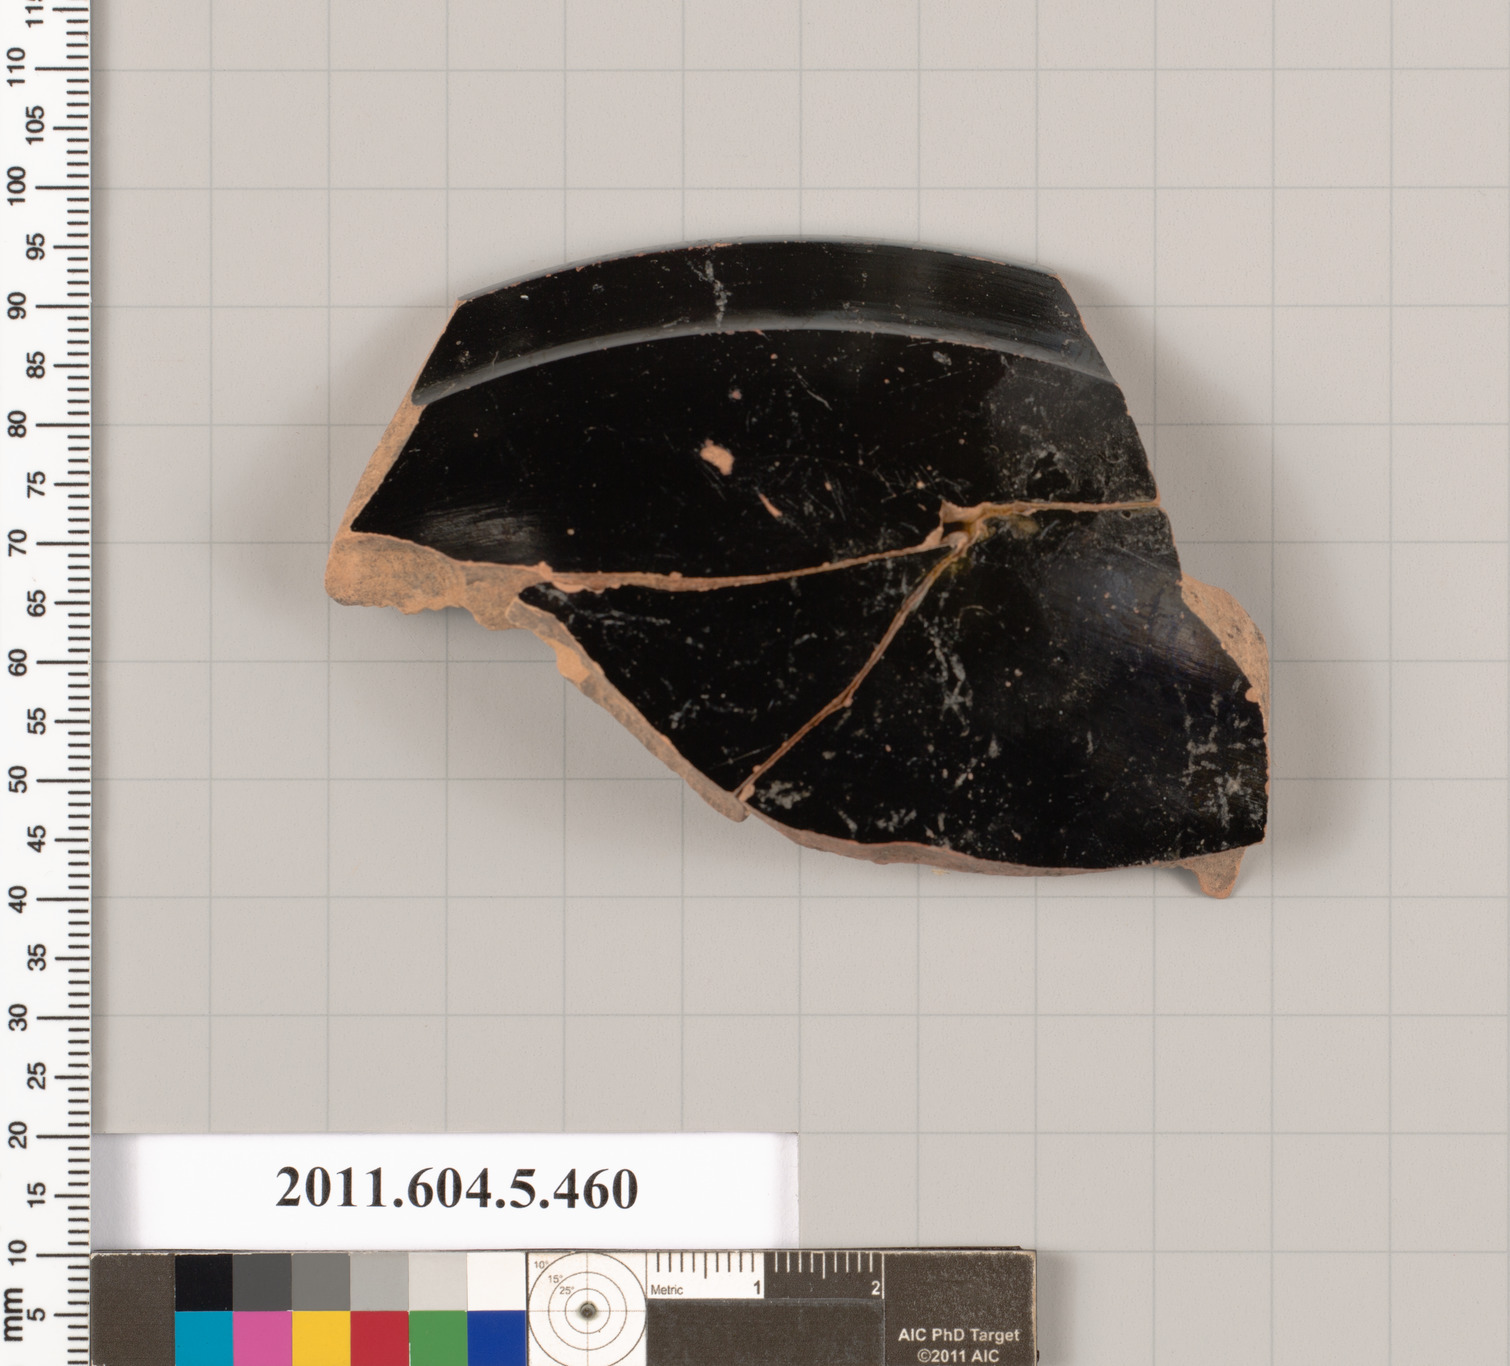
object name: kylix fragment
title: Terracotta rim fragment of a stemless kylix (drinking cup)?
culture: greek, attic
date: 600-401 BCE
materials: terracotta